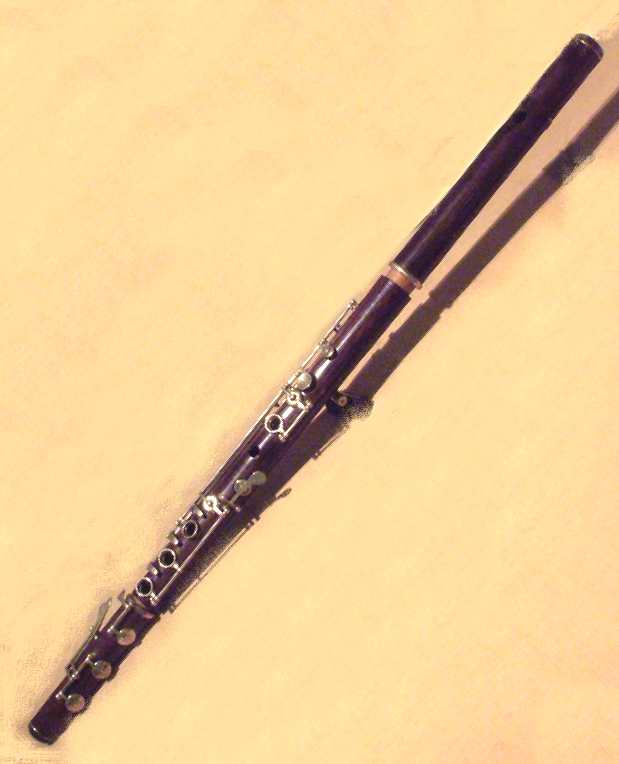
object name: transverse flute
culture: german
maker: boehm & greve, german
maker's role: maker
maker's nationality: german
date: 1840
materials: wood, silver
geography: germany